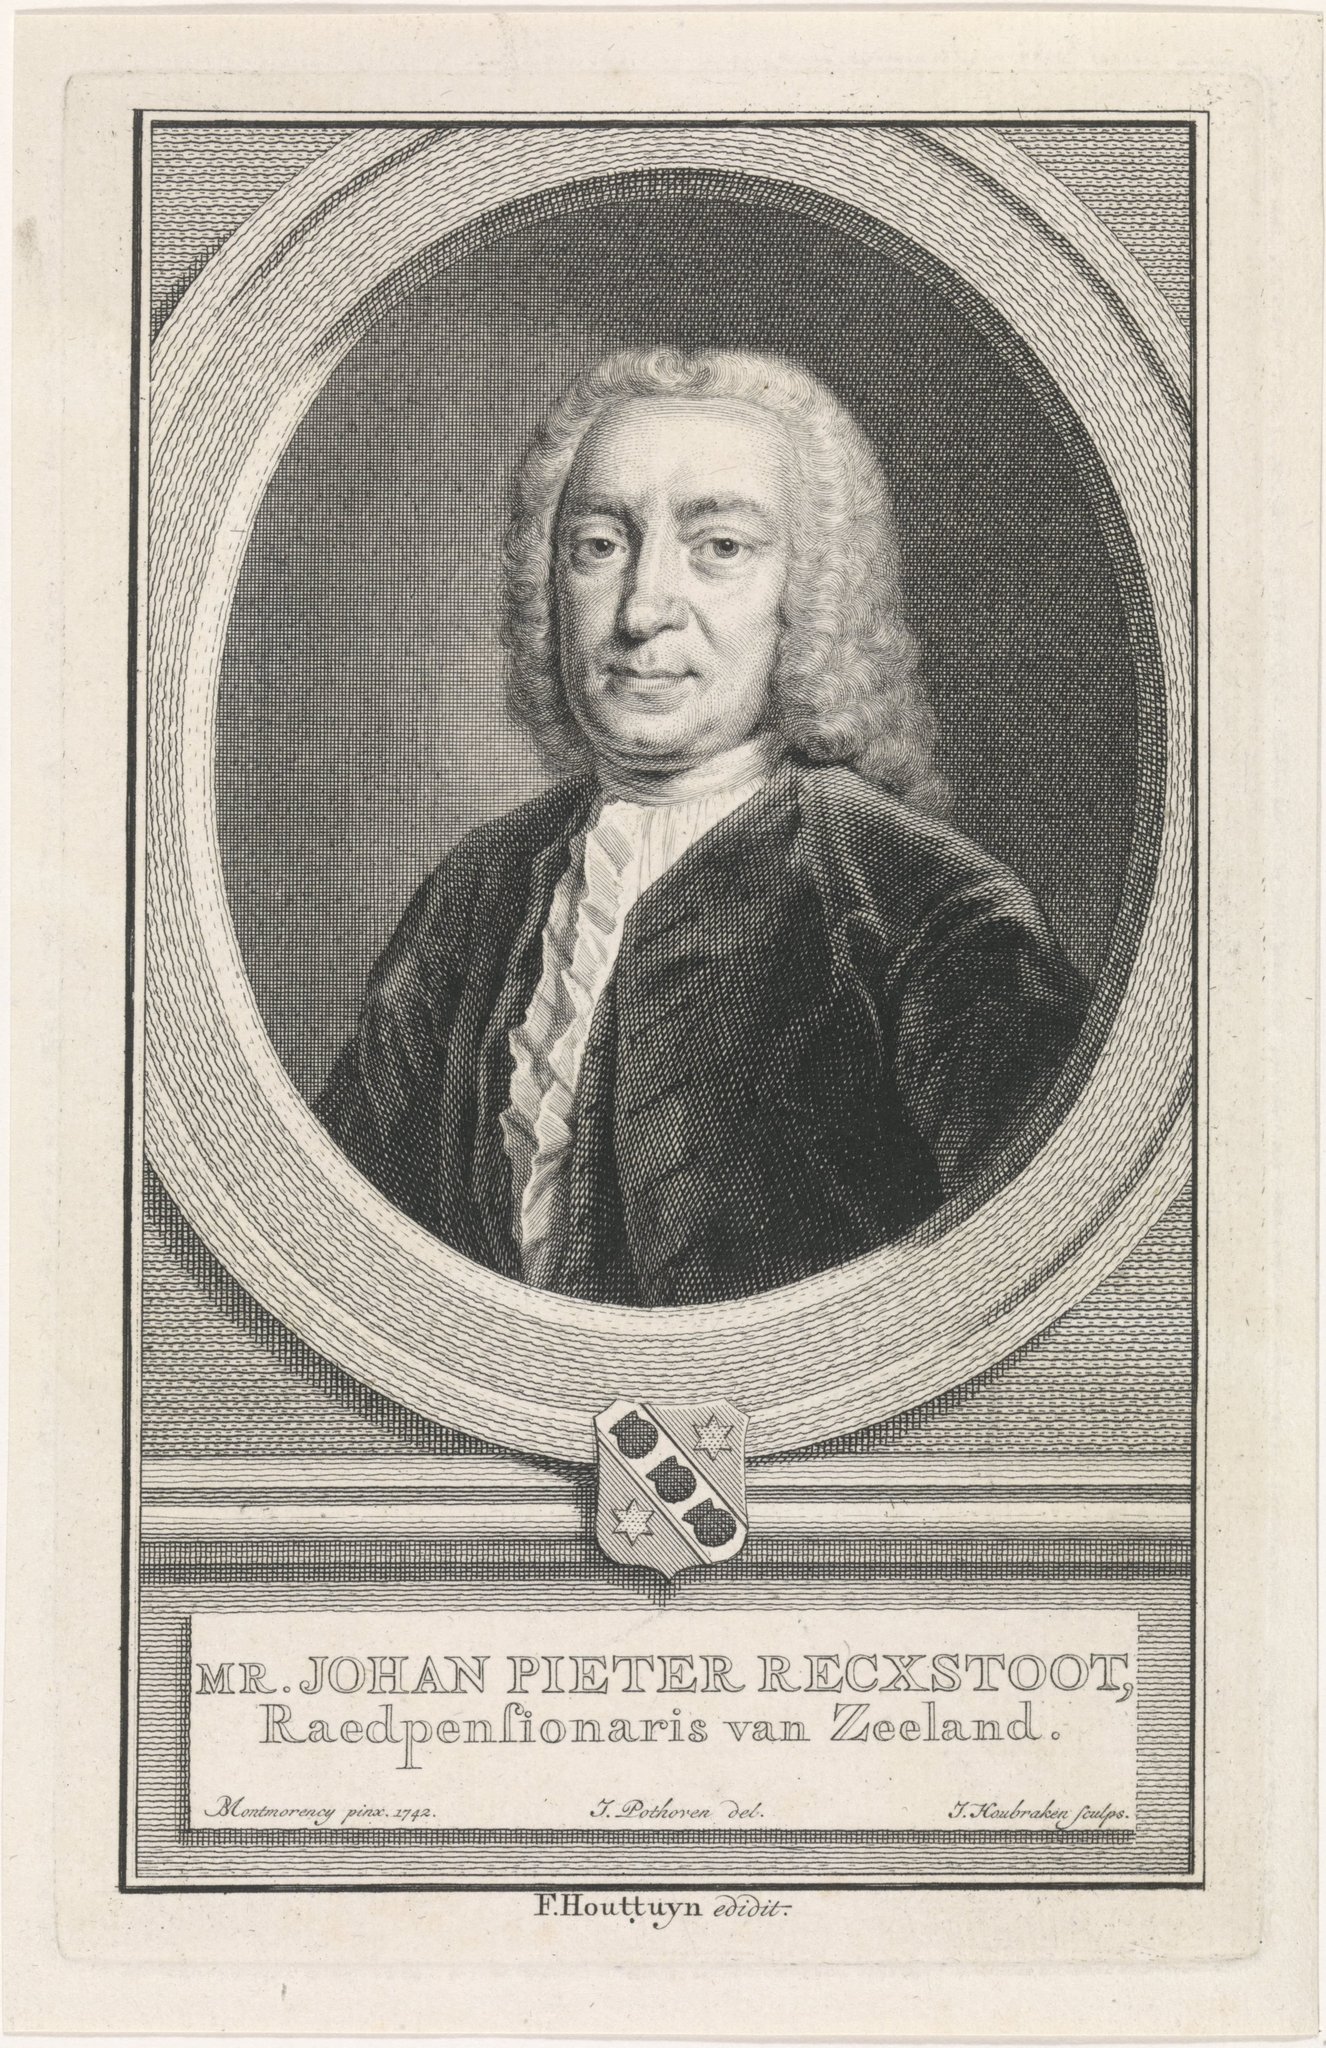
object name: print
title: Mr. Johan Pieter Recxstoot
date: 1745-1765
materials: paper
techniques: engraving, etching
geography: amsterdam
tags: johan pieter recxstoot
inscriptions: collector's mark: Lugt 240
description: Buste naar links van Johan Pieter Recxstoot in een ovaal, met onderaan zijn familiewapen. het portret rust op een richel waarop zijn naam en titel in twee regels in het Nederlands.